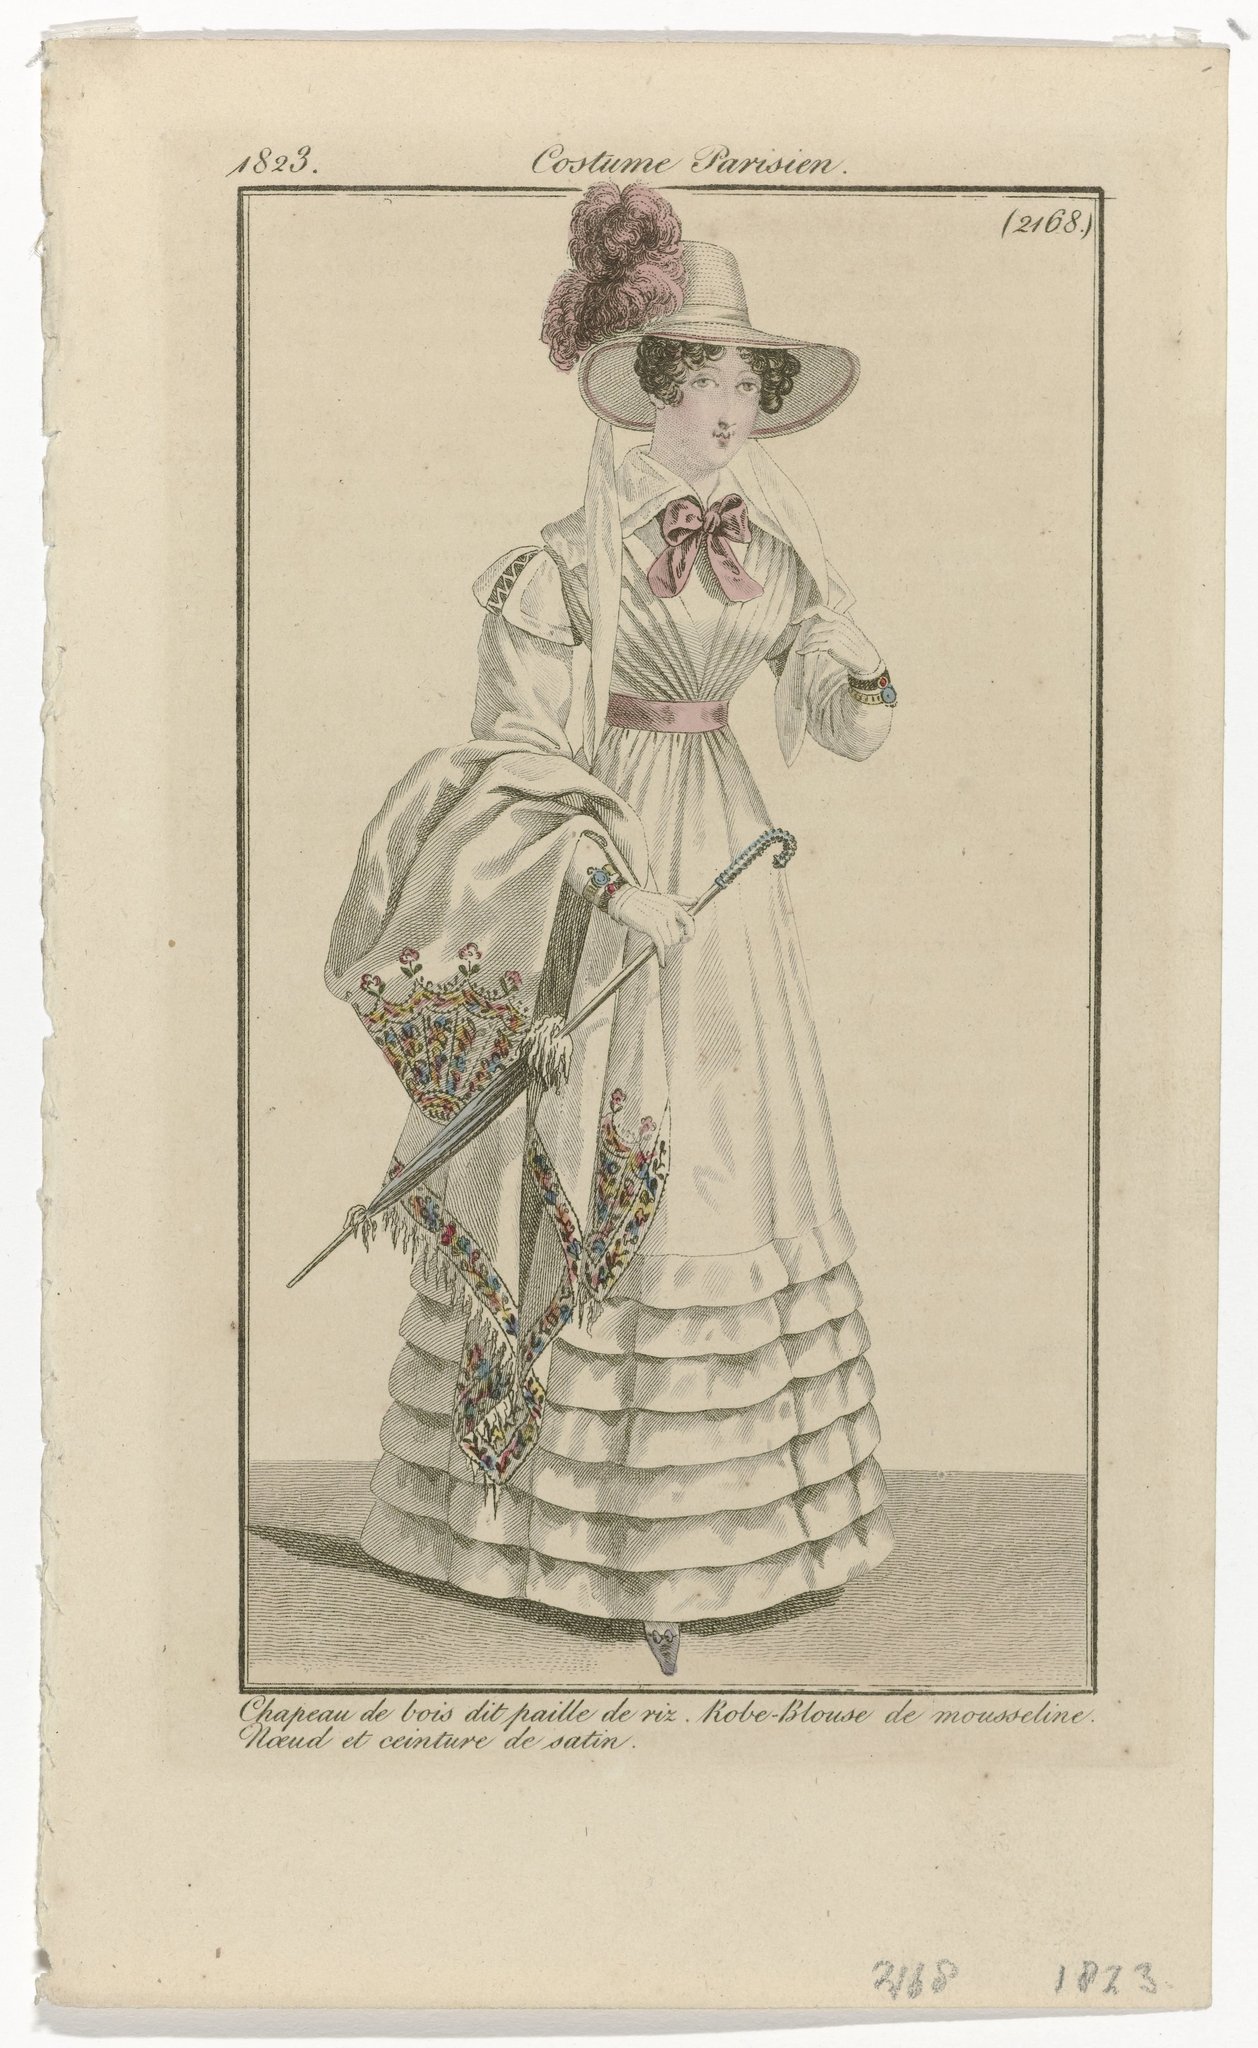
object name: fashion print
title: Journal des Dames et des Modes, Costume Parisien, 25 juillet 1823, (2168): Chapeau de bois dit paille de riz (...)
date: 1823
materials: paper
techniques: engraving, hand coloring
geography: paris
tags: bow (ornamental part of clothing) (+ women's clothes), clothing for the upper part of the body (shawl) (+ women's clothes), fashion plates, head-gear: hat (+ women's clothes), shoes, sandals (+ women's clothes), gloves, mittens, etc. (+ women's clothes), dress, gown (+ women's clothes), bracelet, wristlet (+ women's clothes), parasol, sunshade (+ women's clothes), belt, girdle, waistband (+ women's clothes)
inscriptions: caption: ‘Chapeau de bois dit paille de riz. Robe-Blouse de mousseline. Noeud et ceinture de satin.’, title: ‘Costume Parisien.’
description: Staande vrouw in een 'robe-blouse' van mousseline. Strik en ceintuur van satijn. Op het hoofd een hoed van 'paille de riz'. Verdere accessoires: handschoenen, armbanden om beide polsen, sjaal afgezet met franjes, parasol, schoen met strik. De prent maakt deel uit van het modetijdschrift Journal des Dames et des Modes, uitgegeven door Pierre de la Mésangère, Parijs, 1797-1839.